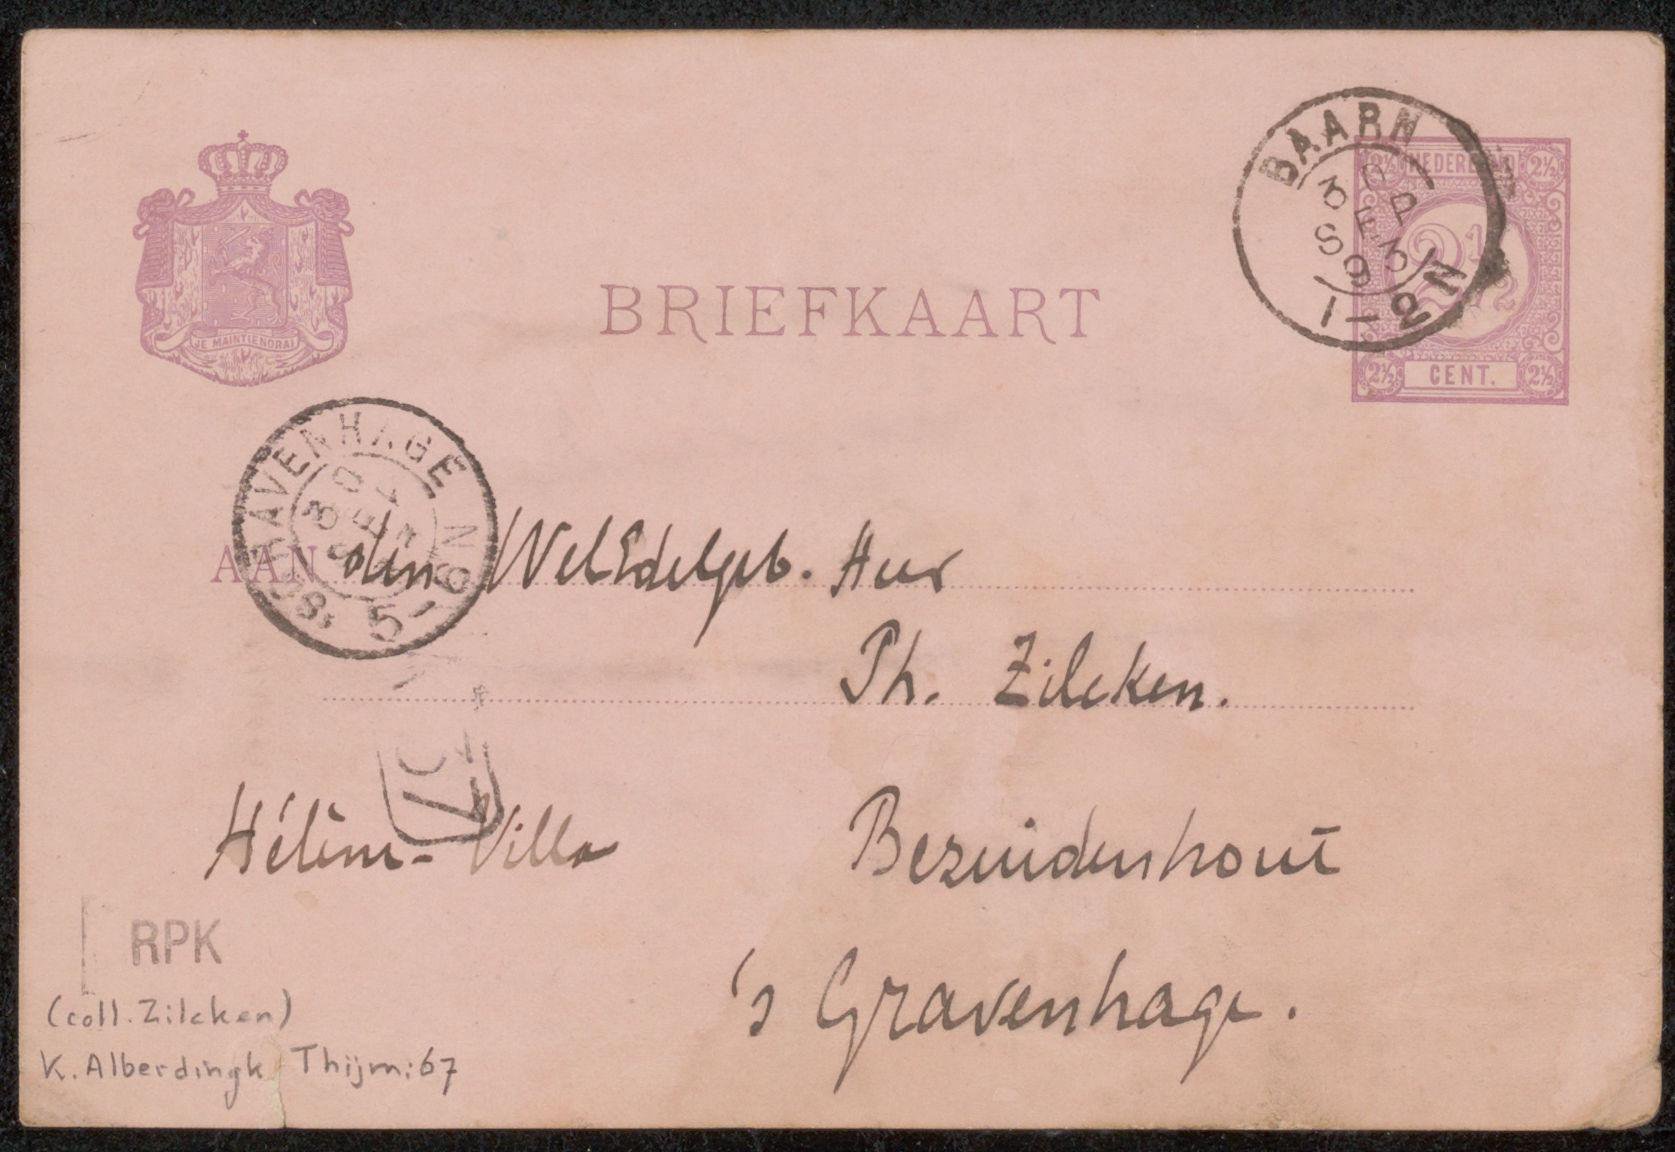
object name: postcard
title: Briefkaart aan Philip Zilcken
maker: karel johan lodewijk alberdingk thijm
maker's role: criticus, prozaschrijver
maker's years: 1864-1952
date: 1893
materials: cardboard, ink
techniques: pen, writing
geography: baarn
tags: painter, draughtsman, philip zilcken, the hague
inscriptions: collector's mark: ‘RPK’